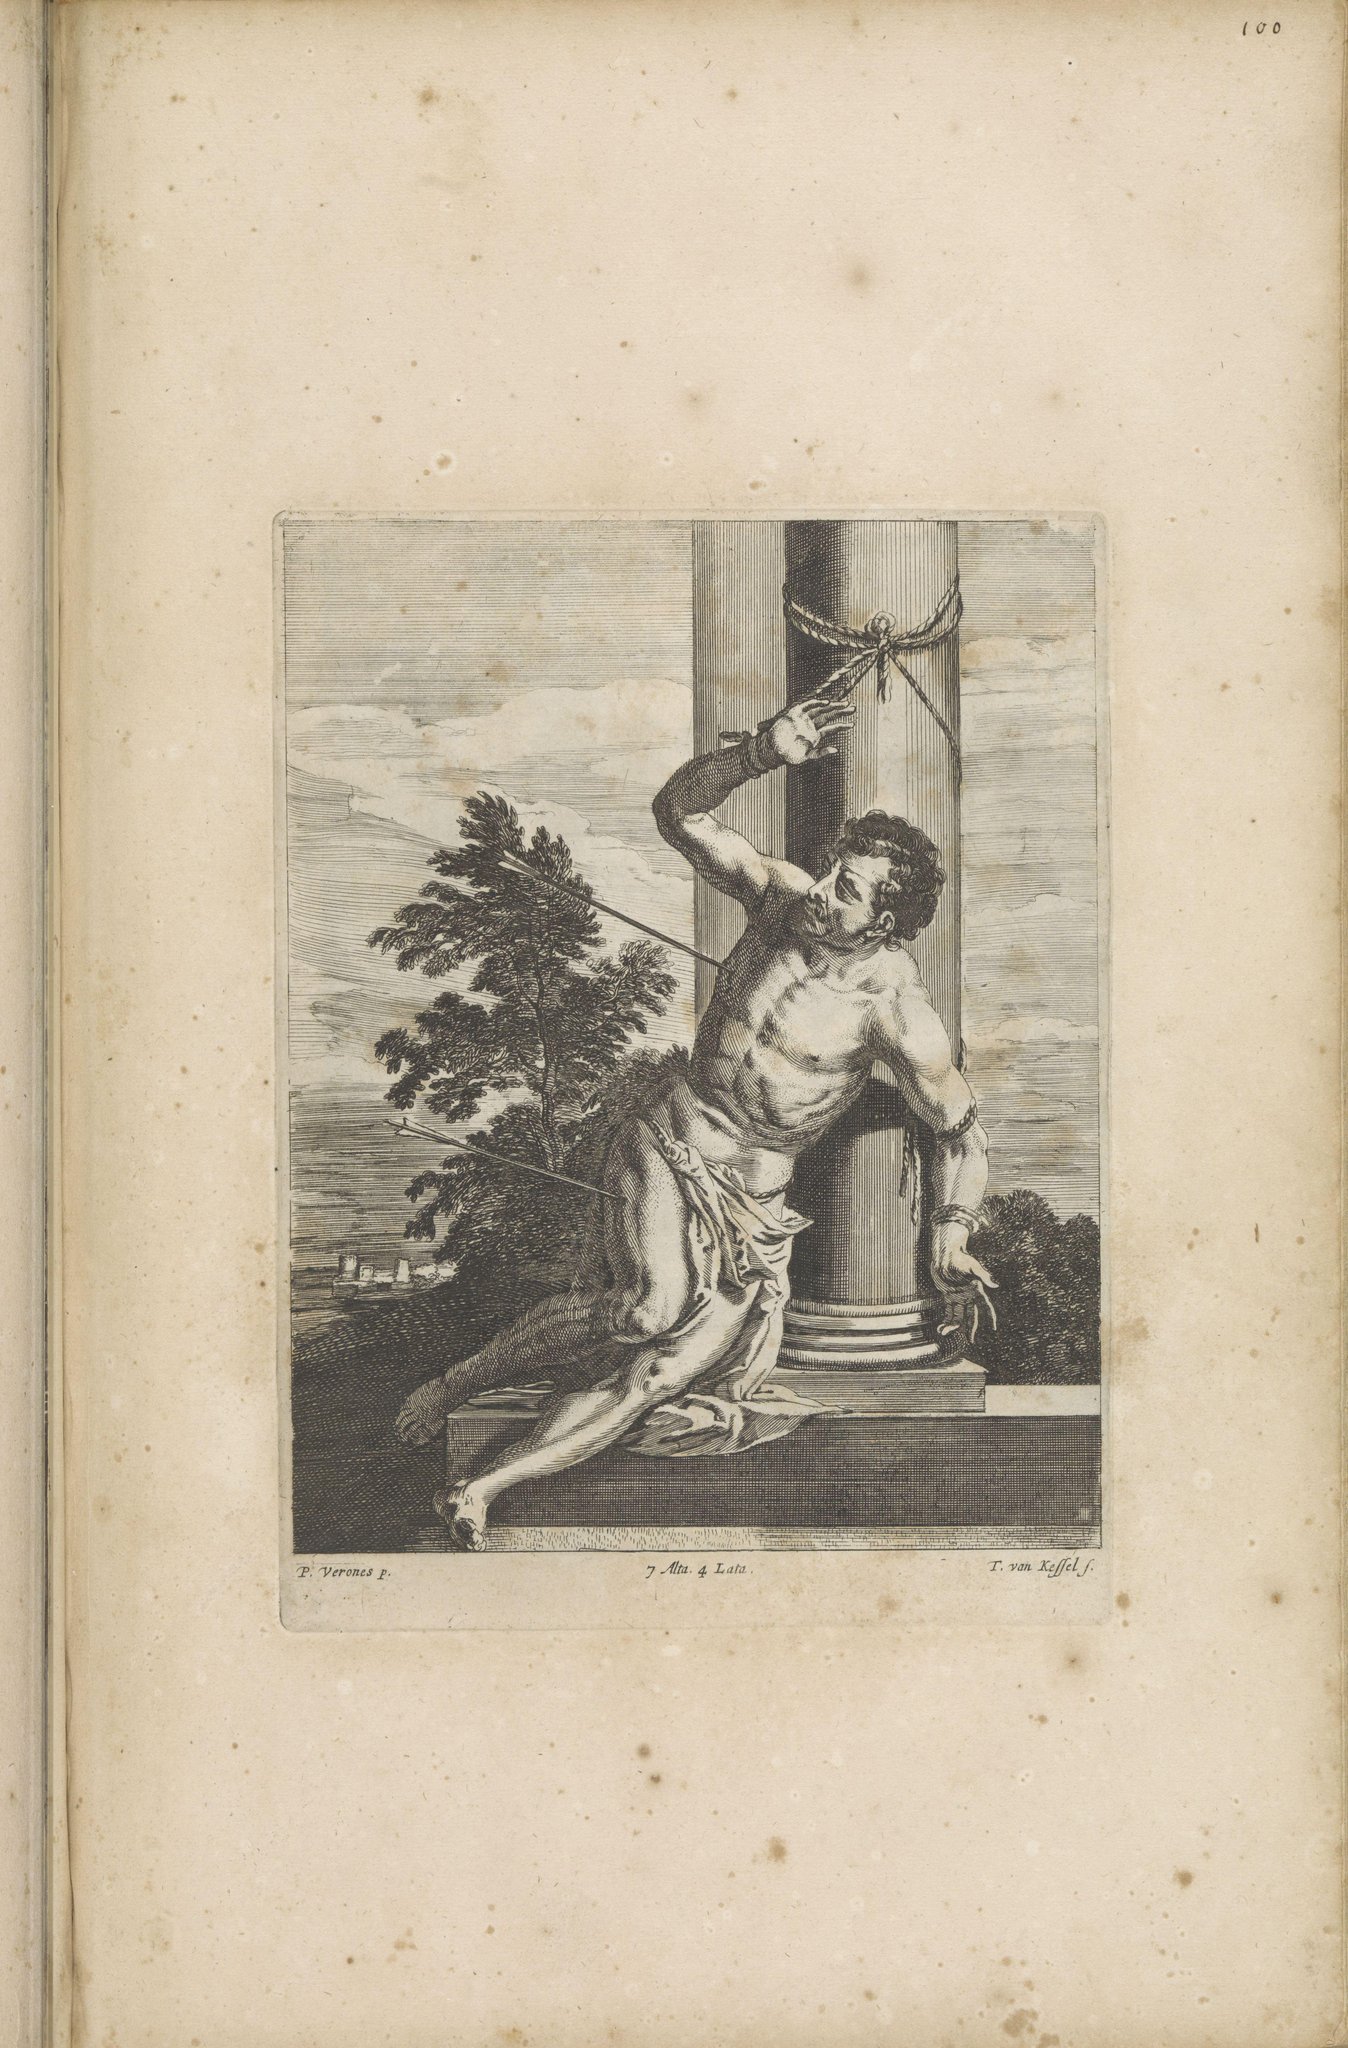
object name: print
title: Martelaarschap van de H. Sebastiaan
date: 1660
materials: paper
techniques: etching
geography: southern netherlands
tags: st. sebastian, tied to a tree or a pillar, is pierced by arrows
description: De prent is vervaardigd naar een schilderij dat is toegeschreven aan Veronese en dat zich in de collectie van het Kunsthistorisches Museum te Wenen bevindt (inventarisnummer GG_1538). David Teniers heeft waarschijnlijk van alle schilderijen uit de collectie van Leopold Willem van Oostenrijk een olieverfstudie op doek of paneel vervaardigd (zgn. pasticcio), die als voorbeeld voor de prentmakers diende. Het is niet altijd duidelijk of de pasticci door hem zijn gemaakt of door zijn atelier. Niet alle pasticci zijn overgeleverd.